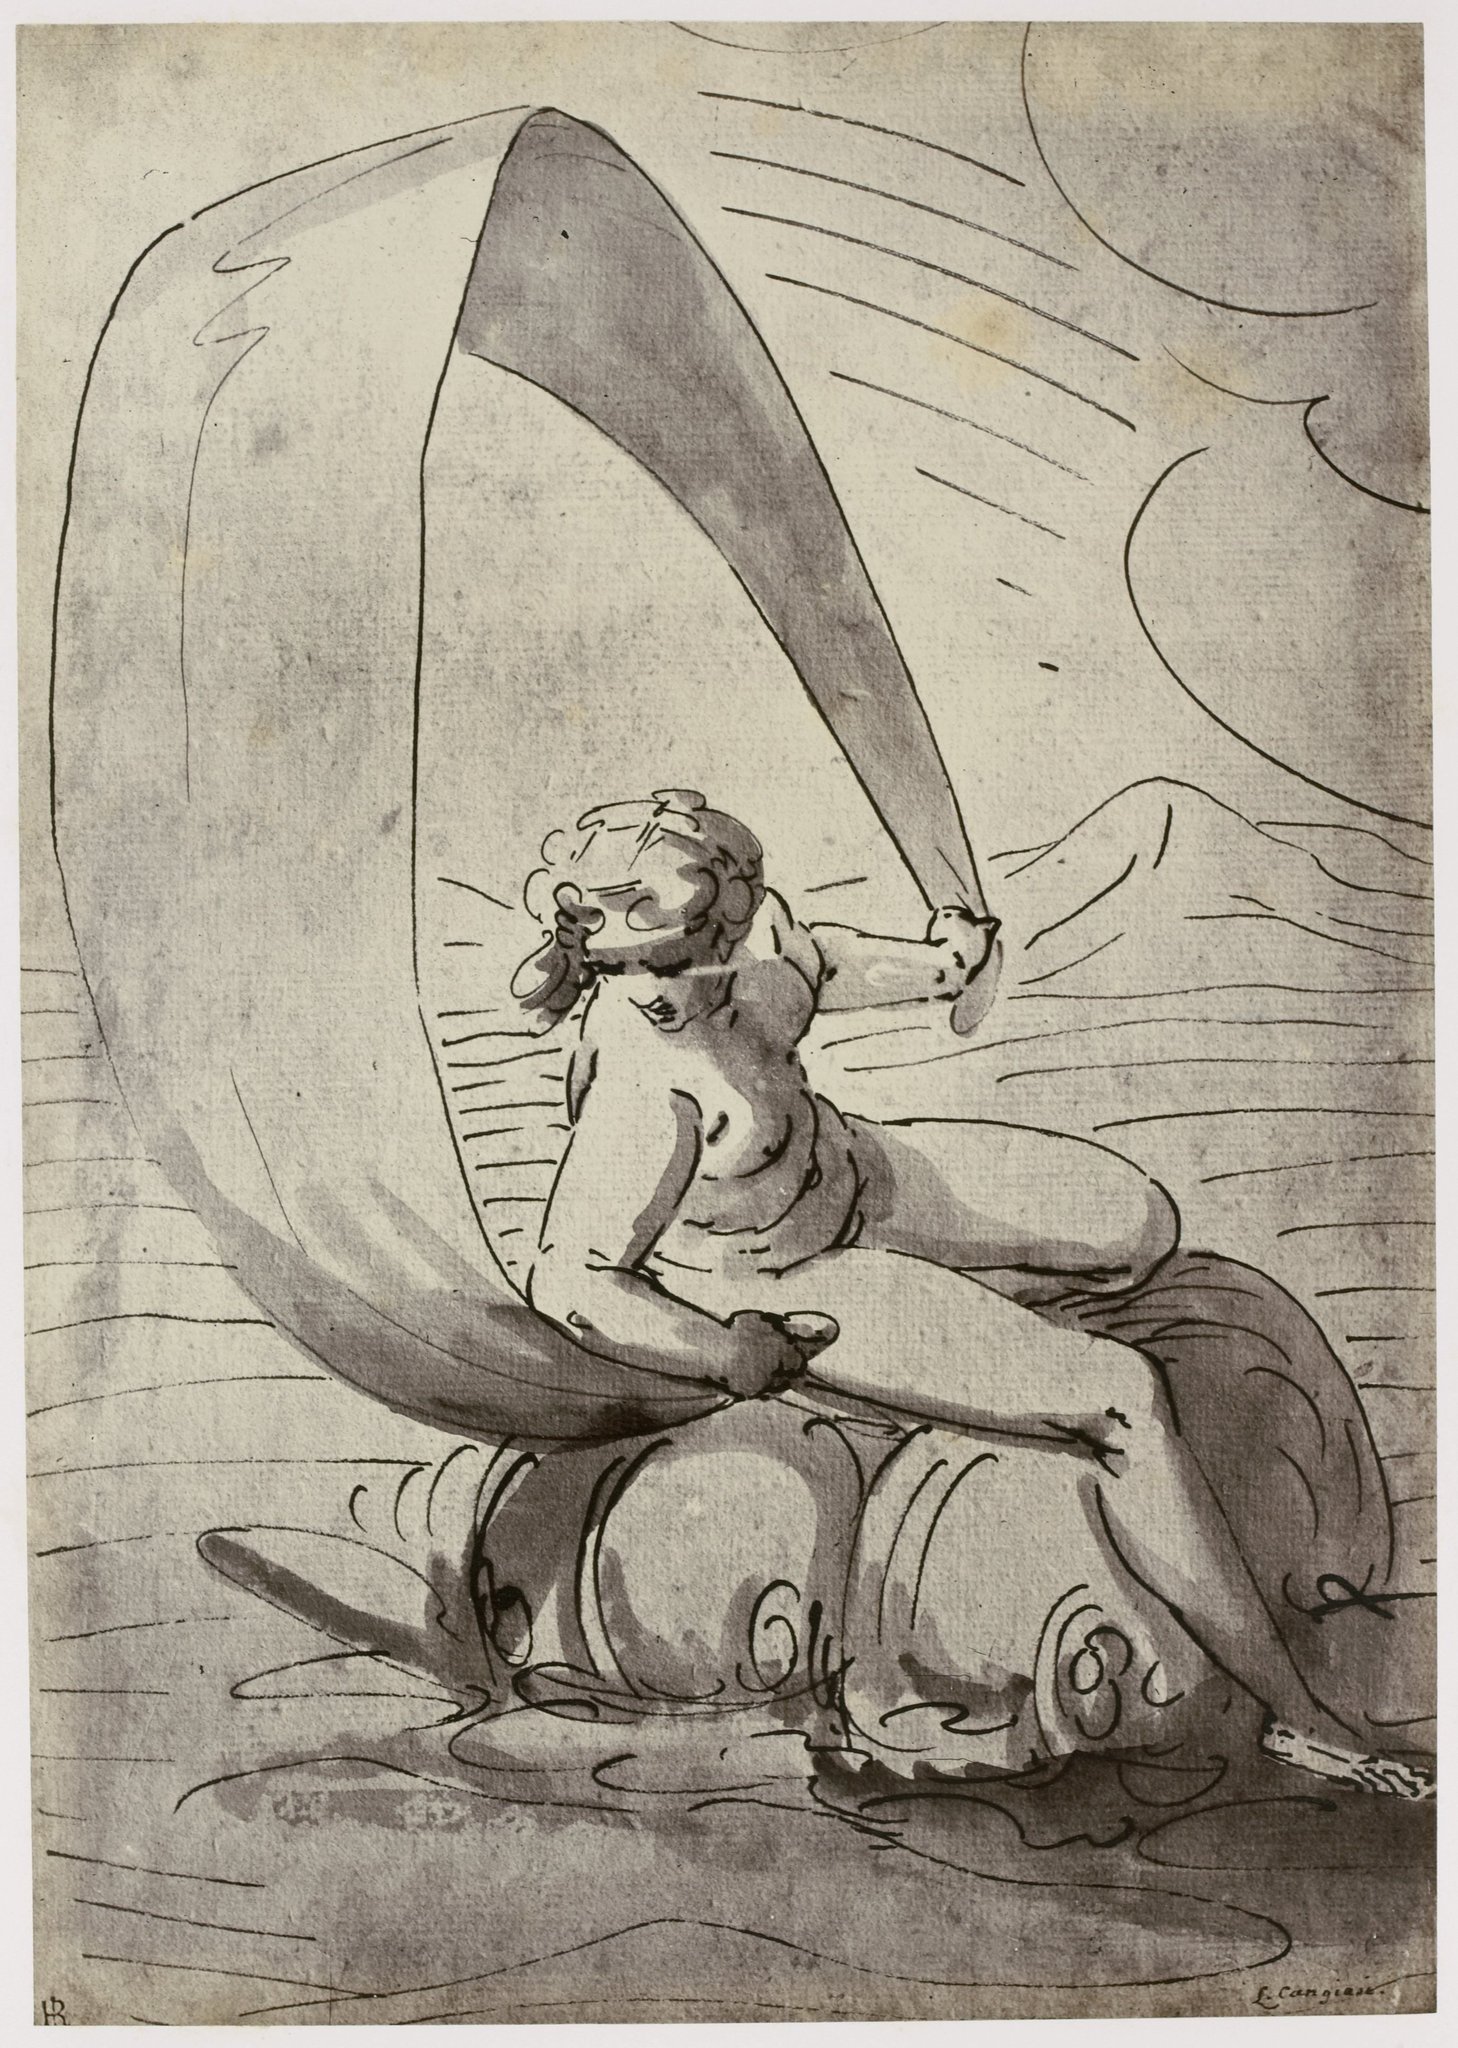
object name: photograph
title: Cangiasi, Galathea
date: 1855-1858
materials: cardboard, paper, photographic support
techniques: albumen print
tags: drawing, sketch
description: Fotoreproductie van tekening in 'The Reveley Collection of Drawings at Brynygwin', afb. 13.